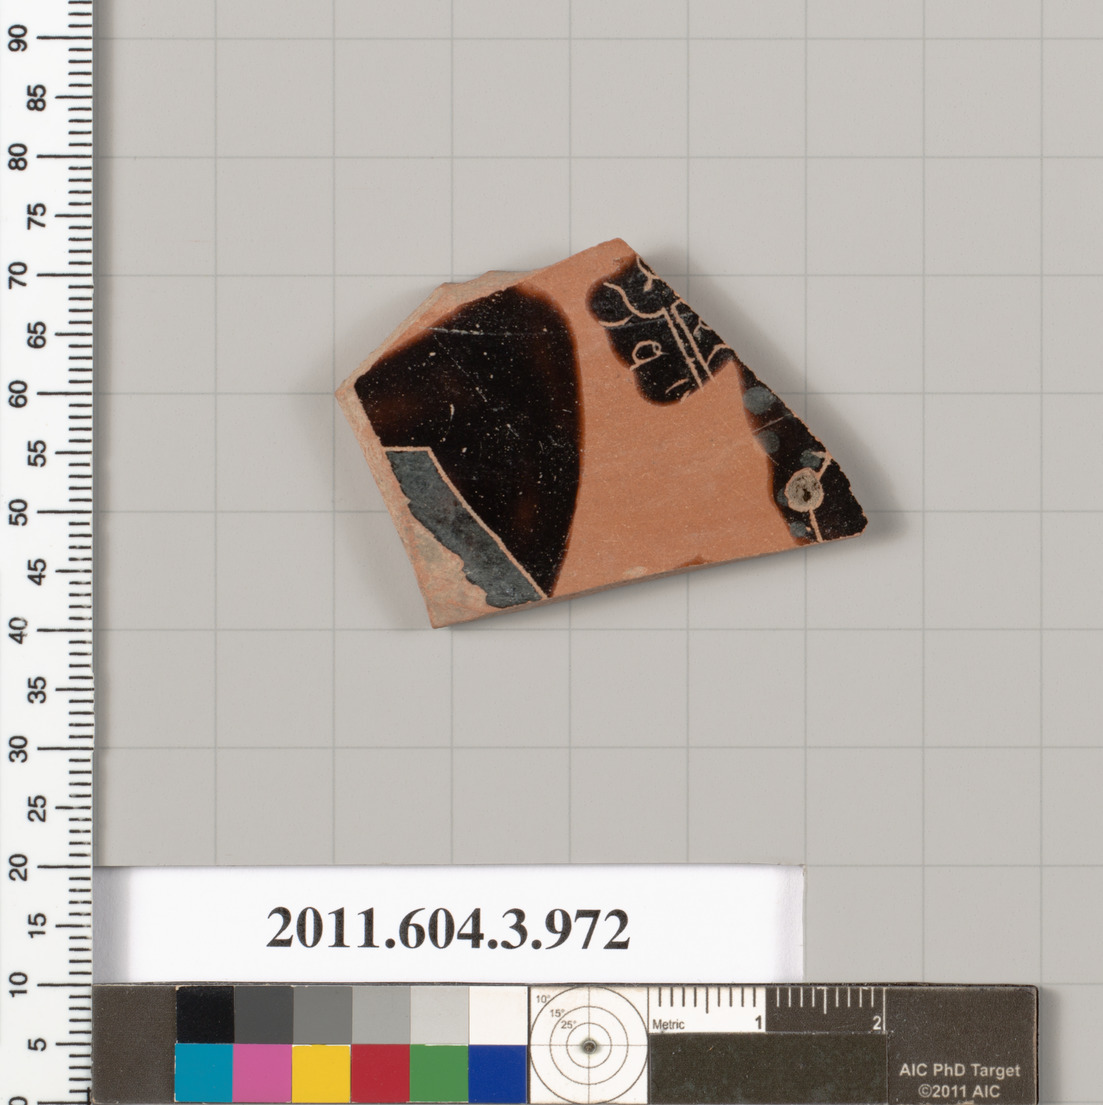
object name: lekanis lid fragment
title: Terracotta fragment of a lekanis lid (covered dish)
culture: greek, attic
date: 575-551 BCE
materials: terracotta